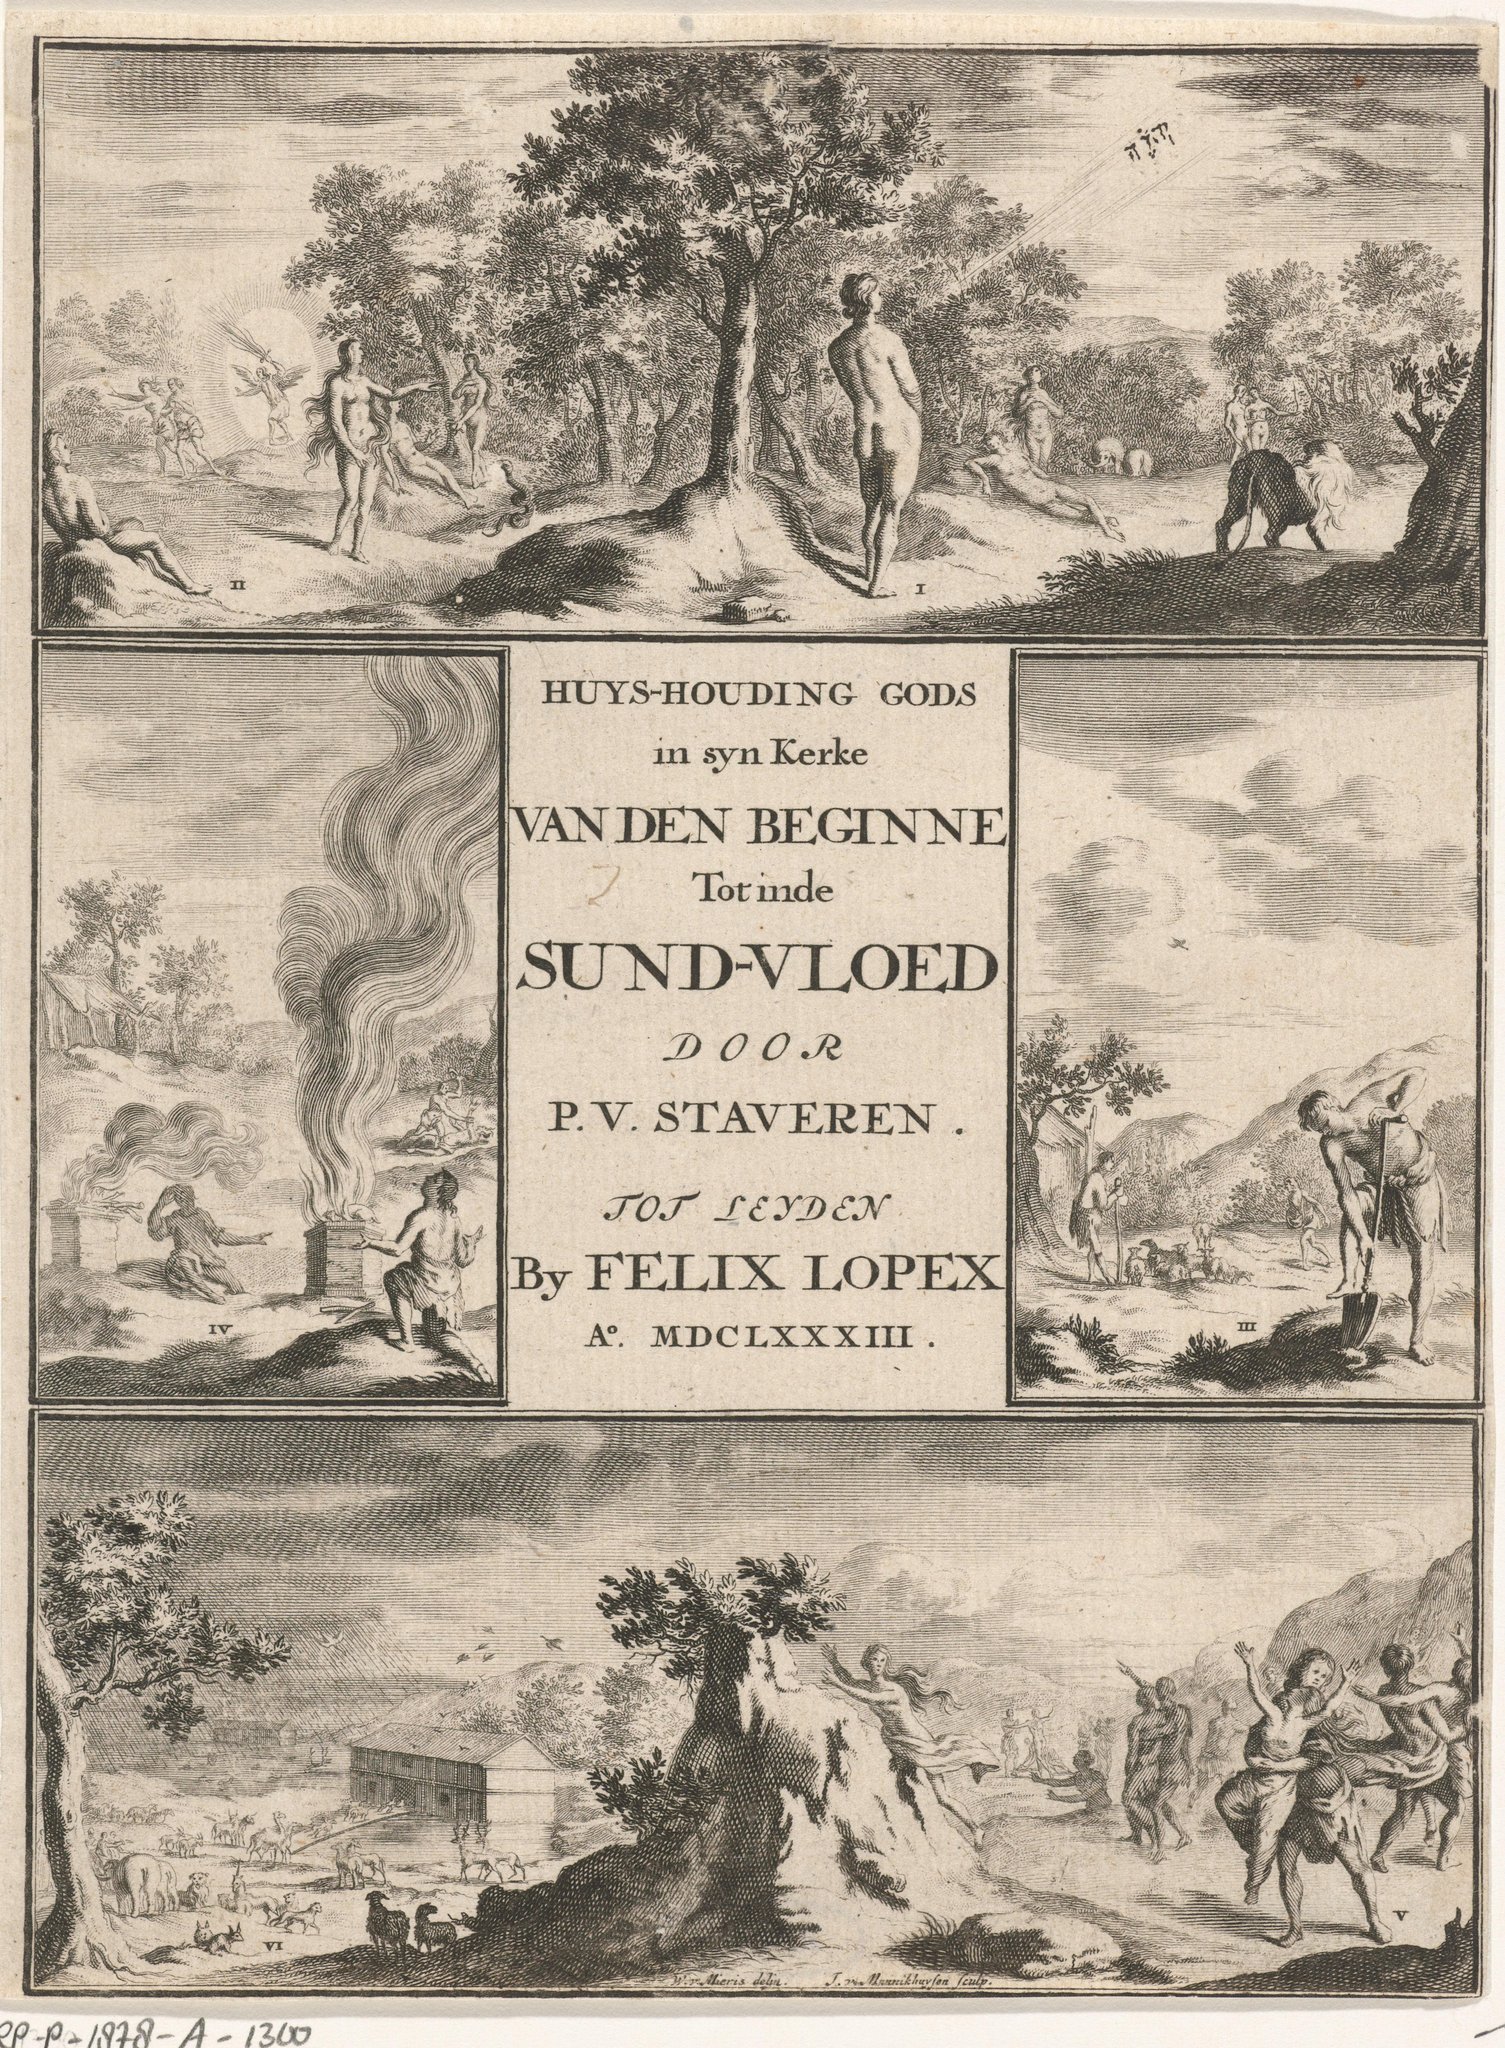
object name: titelblad, titelpagina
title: Titelpagina voor: P. van Staveren, De huyshoudinge Gods in sĳn kerke, van den beginne des werelds tot aan, ende in, de sundvloed, 1683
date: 1683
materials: paper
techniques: engraving, etching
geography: leiden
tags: the embarkation of the ark, cain and abel learn to assist their father; cain by farming, abel by herding, creation of man; the garden of eden (genesis 1:26 - 2), expulsion of adam and eve from paradise (genesis 3:22-24), the wickedness of mankind; the wicked are usually shown feasting and revelling, the story of cain and abel (genesis 4:3-17)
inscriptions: collector's mark: Lugt 2228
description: Vier genummerde voorstellingen uit het Oude Testament. Boven: de schepping van Eva, de verzoeking en de verdrijving uit het paradijs. Rechts van het midden: Kaïn bewerkt het land en Abel past op het vee. Links van het midden: de offers van Kaïn en Abel en op de achtergrond Kaïn, die zijn broer Abel doodslaat. Midden onder: de dieren betreden de ark van Noach, terwijl de mensen rechts zich overgeven aan losbandig gedrag.